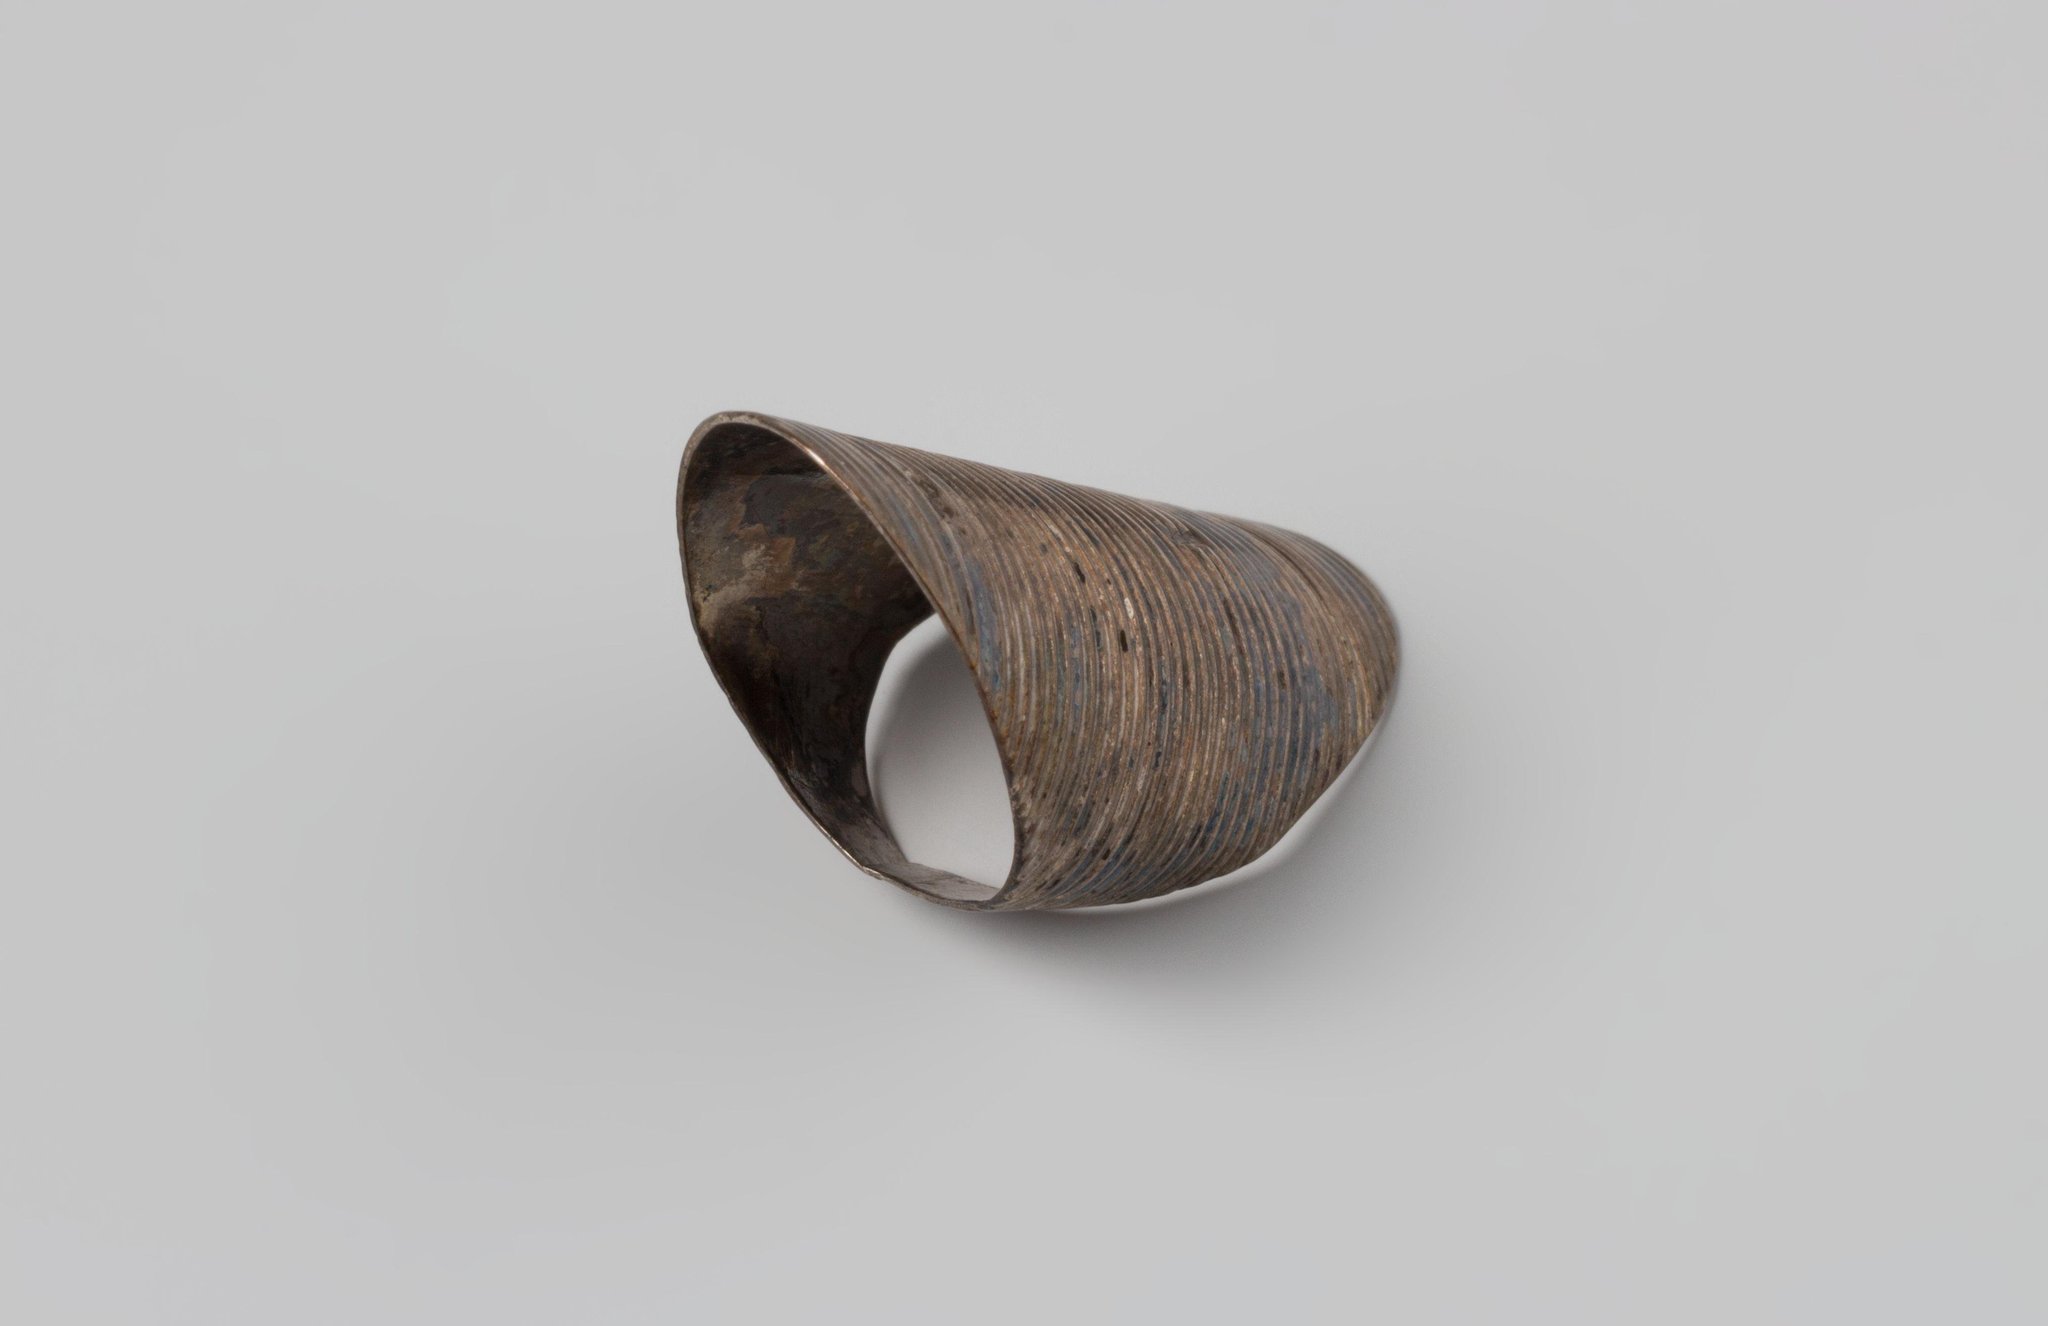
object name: thimble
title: Vingerhoed van zilver, als een platte ring met breed nagelbeschermend bovengedeelte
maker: Anonymous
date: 1817-1820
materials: silver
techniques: forging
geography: groningen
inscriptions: mark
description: Vingerhoed van zilver, als een platte ring met breed nagelbeschermend bovengedeelte en een smal ondergedeelte; om het eerste vingerkootje vrij te laten bewegen bij het naaien. Merken: Zwaantje, voor Groningen en W. S., W. Schutter.